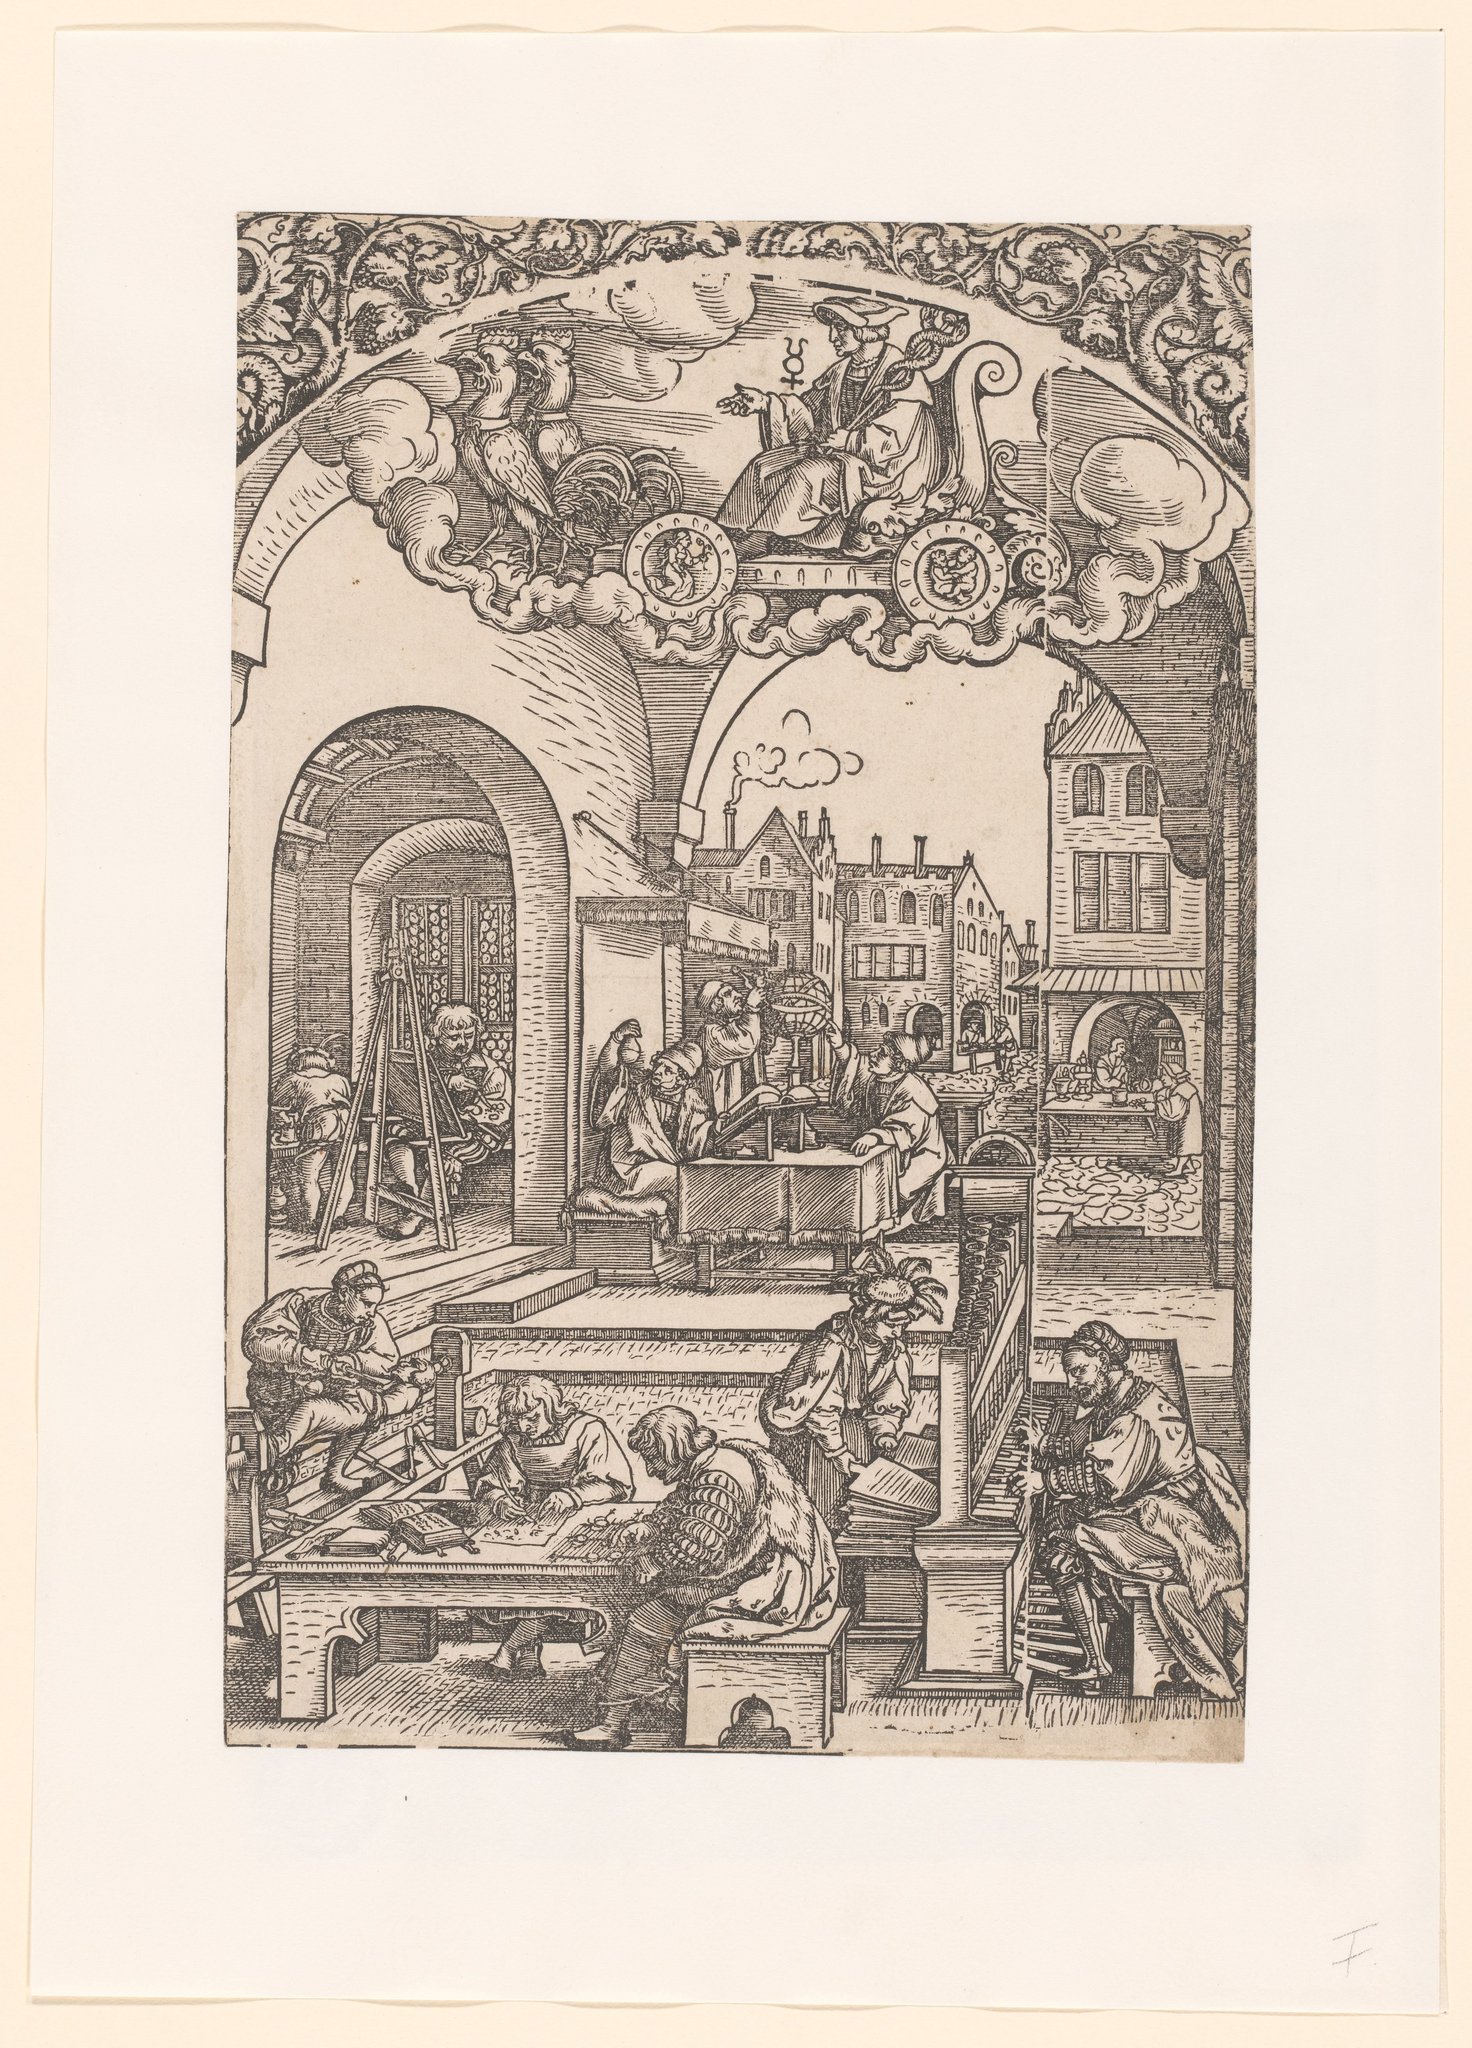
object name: print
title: Planeetkinderen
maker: Anonymous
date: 1510-1550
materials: paper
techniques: woodcut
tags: sculptor at work, mercury and his children ('planetenkinder'), painter at work, in his studio - cc - out of doors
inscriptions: collector's mark: Lugt 240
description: In de loop van de 15de eeuw ontstonden diverse gegraveerde en geschilderde series over de planeten en hun 'kinderen': de mensen op aarde, die, naar men dacht, de invloed van de sterren en planeten ondergingen. De kinderen van Mercurius zijn intelligent, ingenieus en mathematisch aangelegd: het zijn handelslieden en geleerden. In de 16de eeuw worden ook de schilders en beeldhouwers tot de kinderen van Mercurius gerekend, om aan te geven dat ook zij over deze kwaliteiten beschikken.